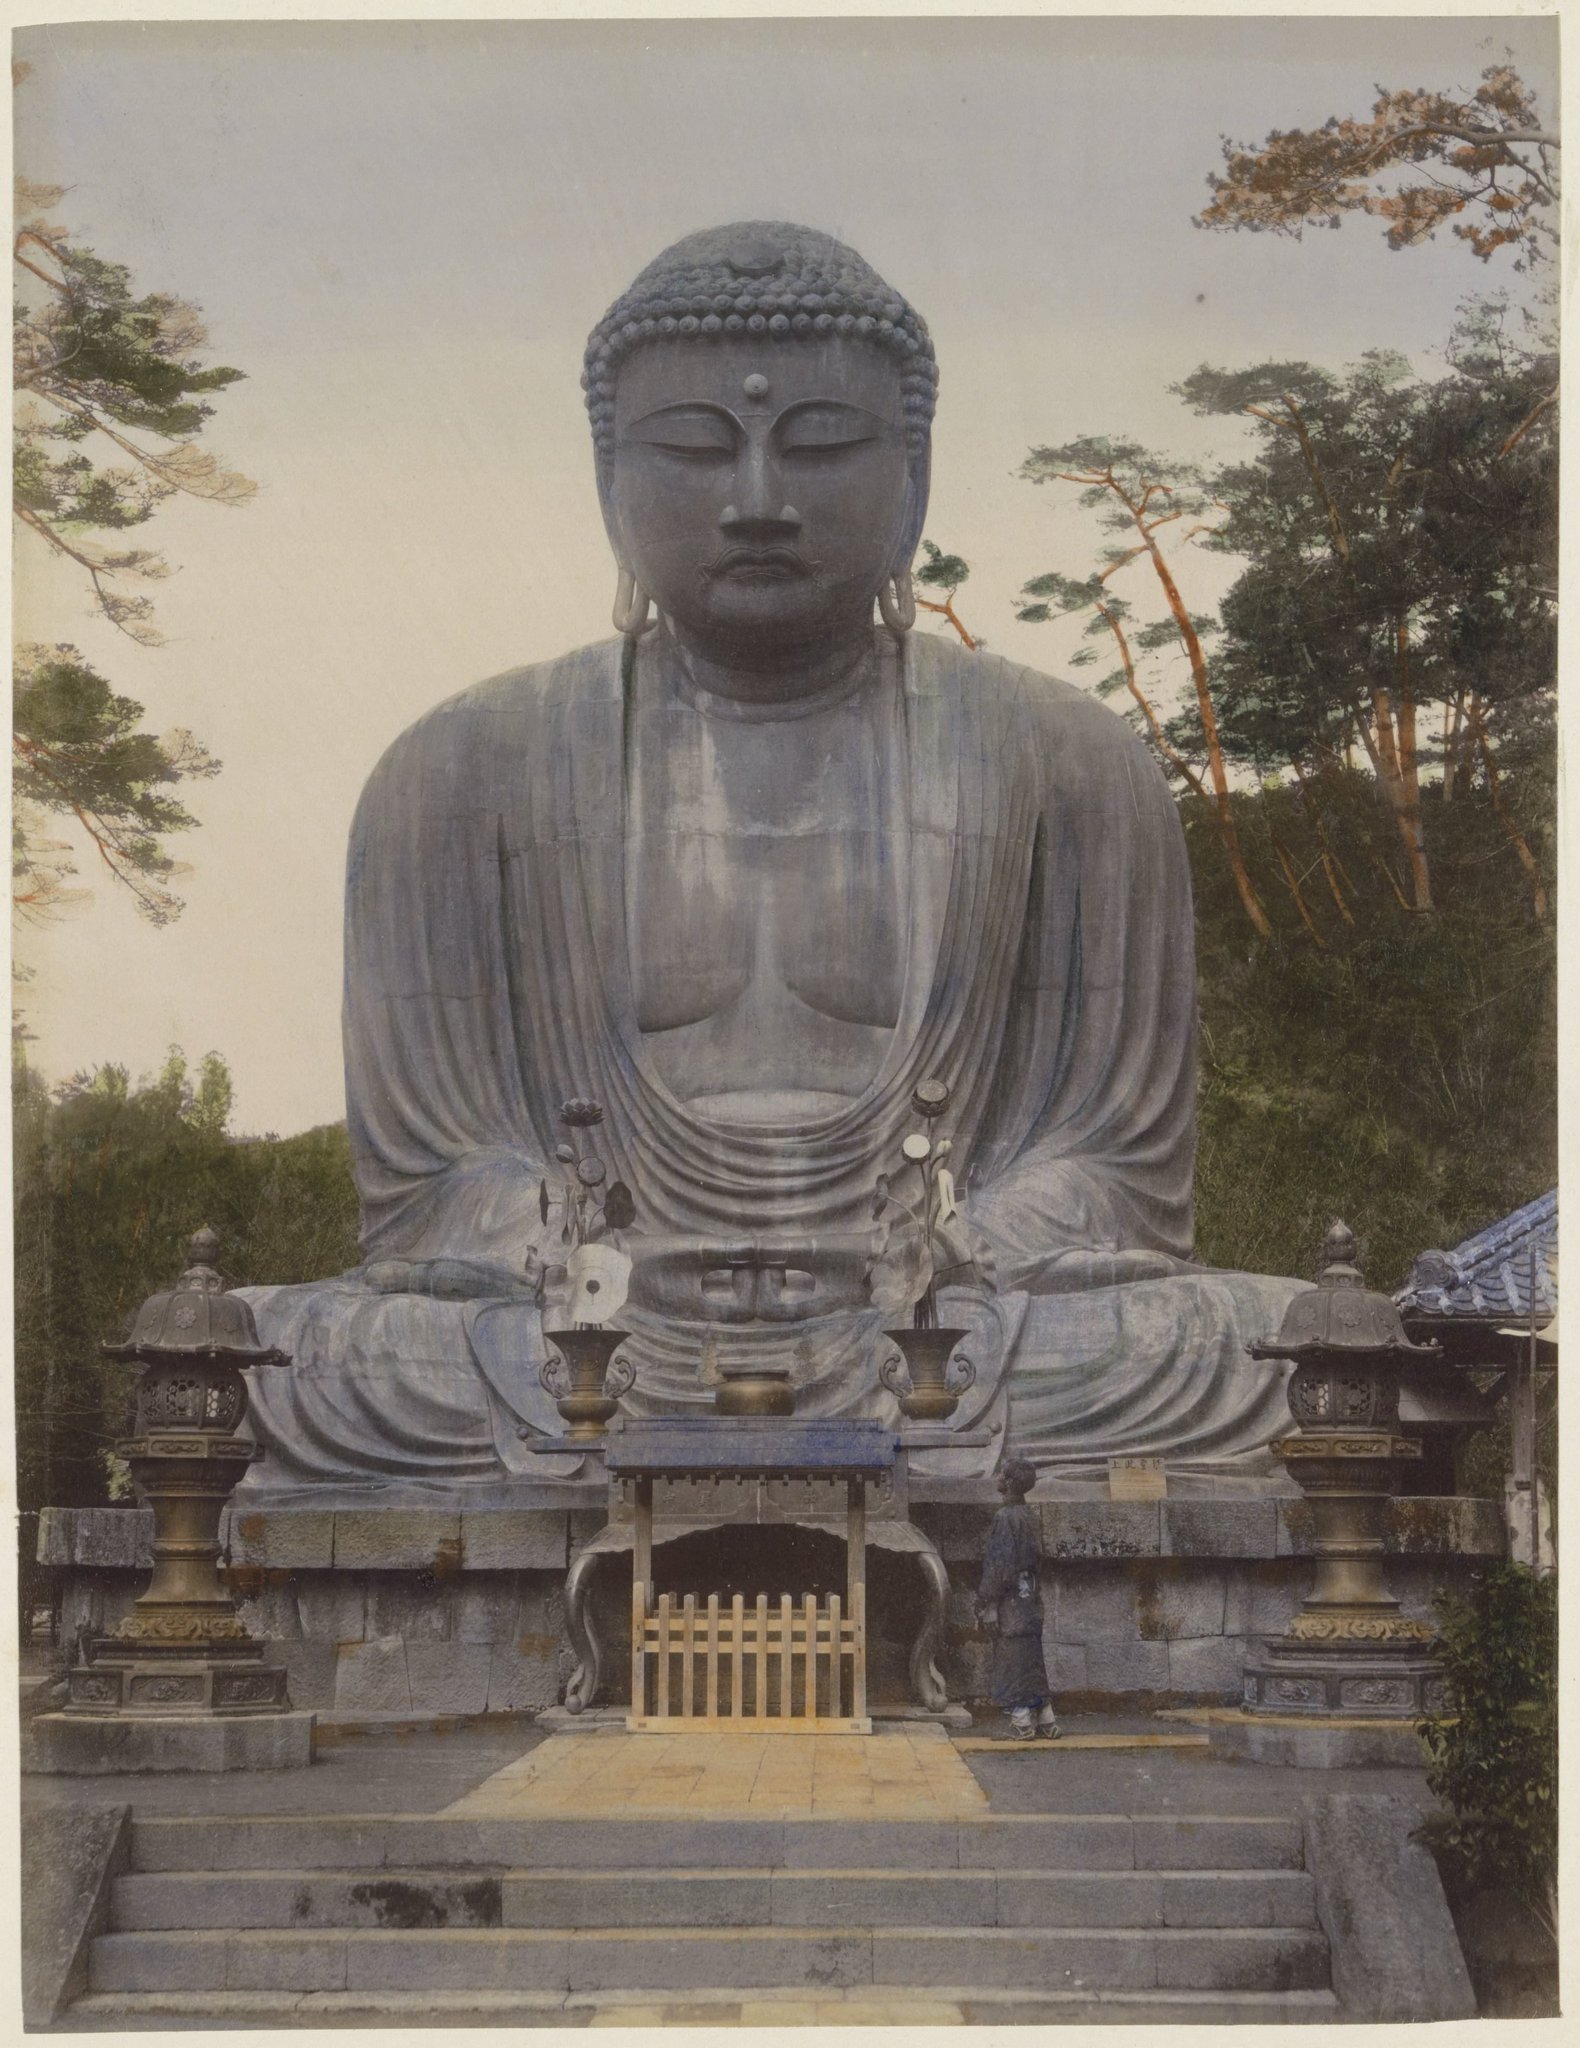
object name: photograph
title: Grote Boeddha (Daibatsu) van Kamakura, van voren gezien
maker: Anonymous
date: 1870-1900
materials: cardboard, paper, photographic support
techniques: albumen print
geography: kamakura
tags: monument, statue, japan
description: Onderdeel van Reisalbum met foto's van bezienswaardigheden in Japan.